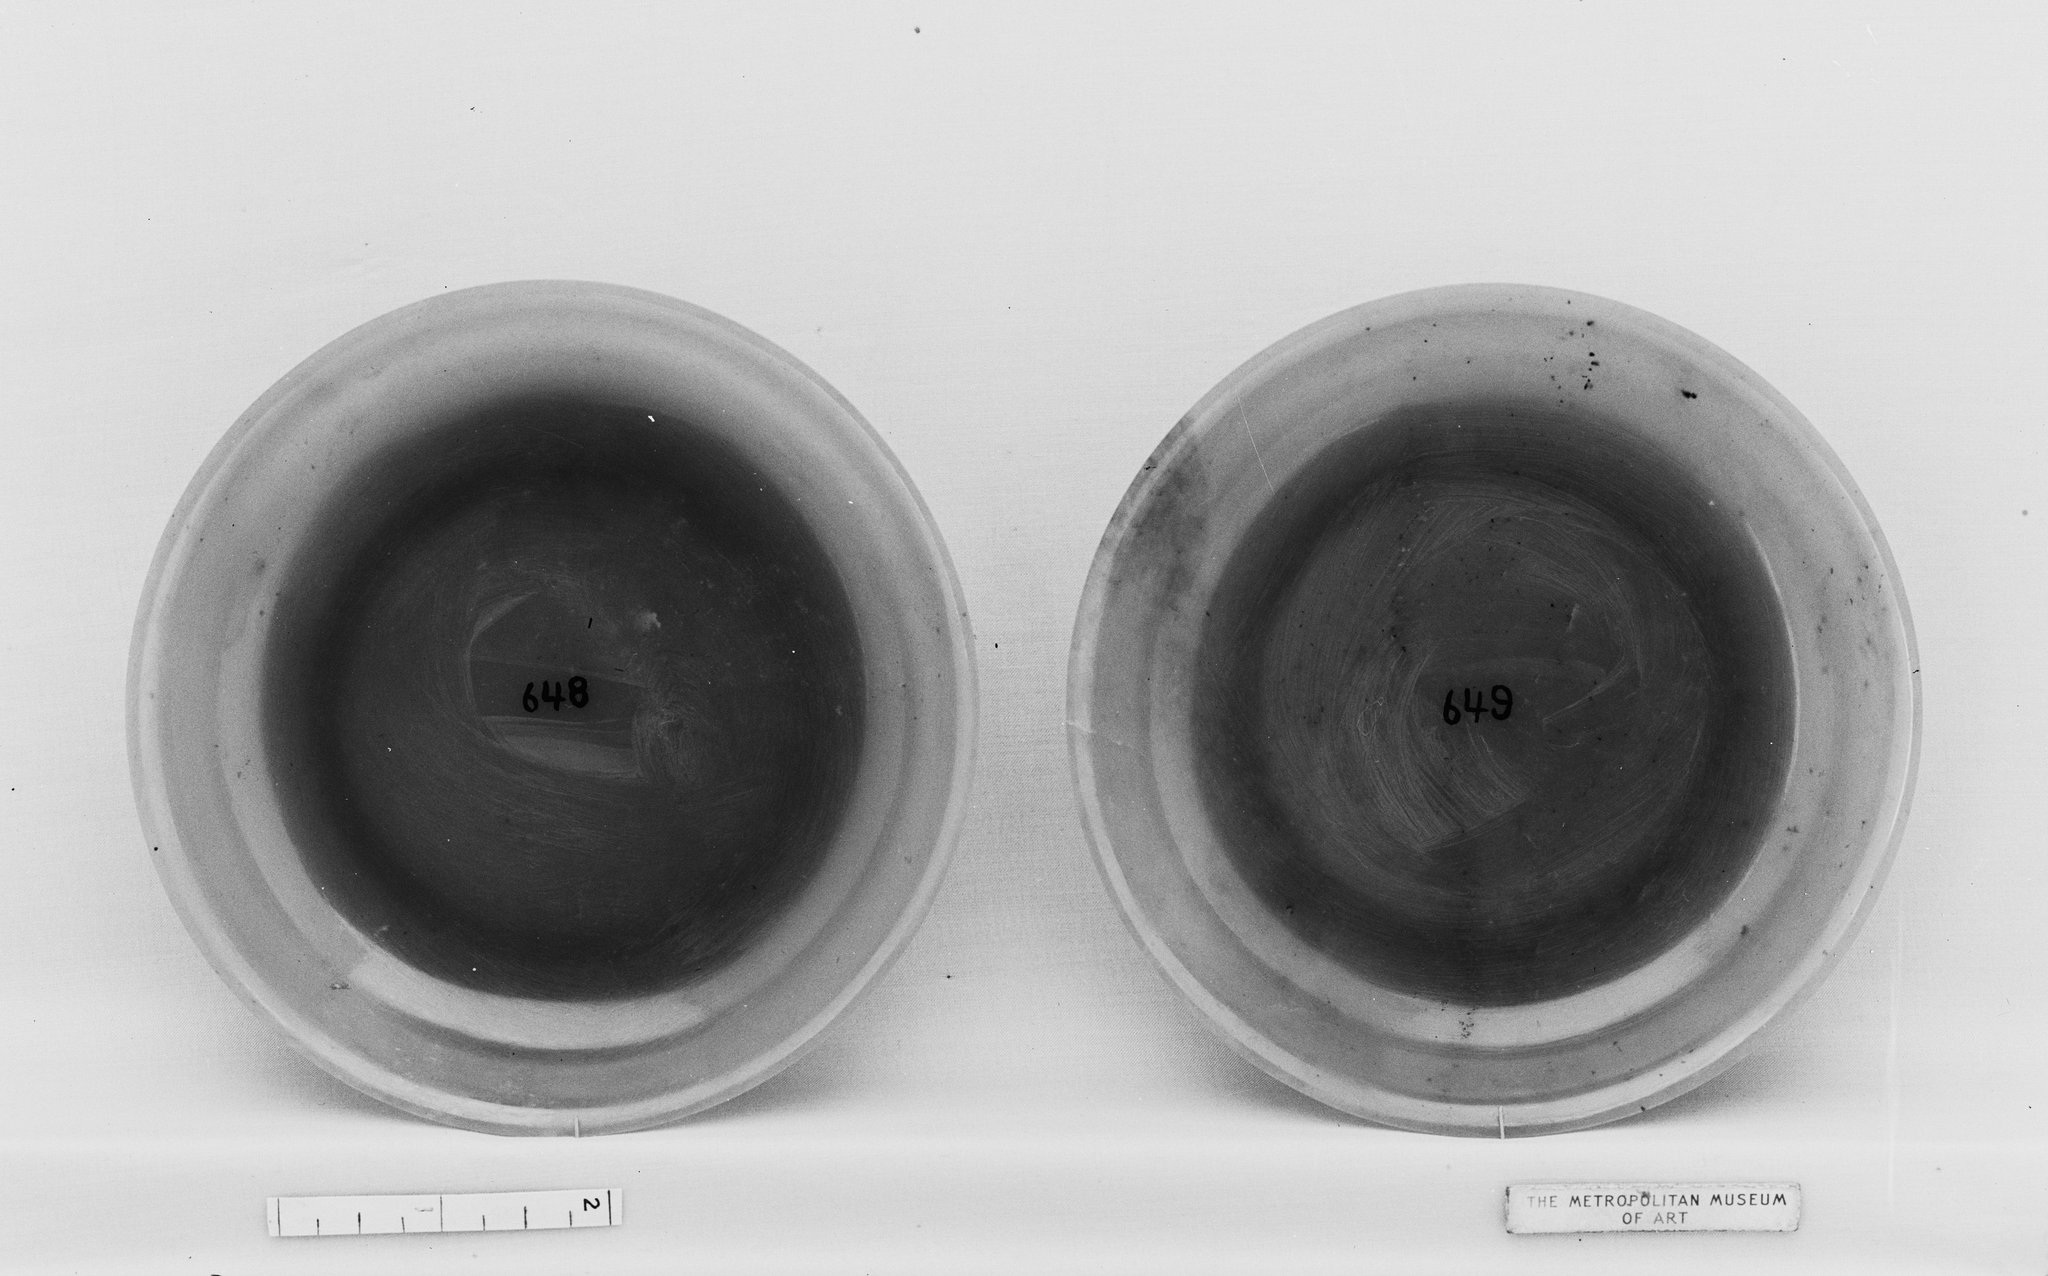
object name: dish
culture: chinese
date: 1736-1795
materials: jade